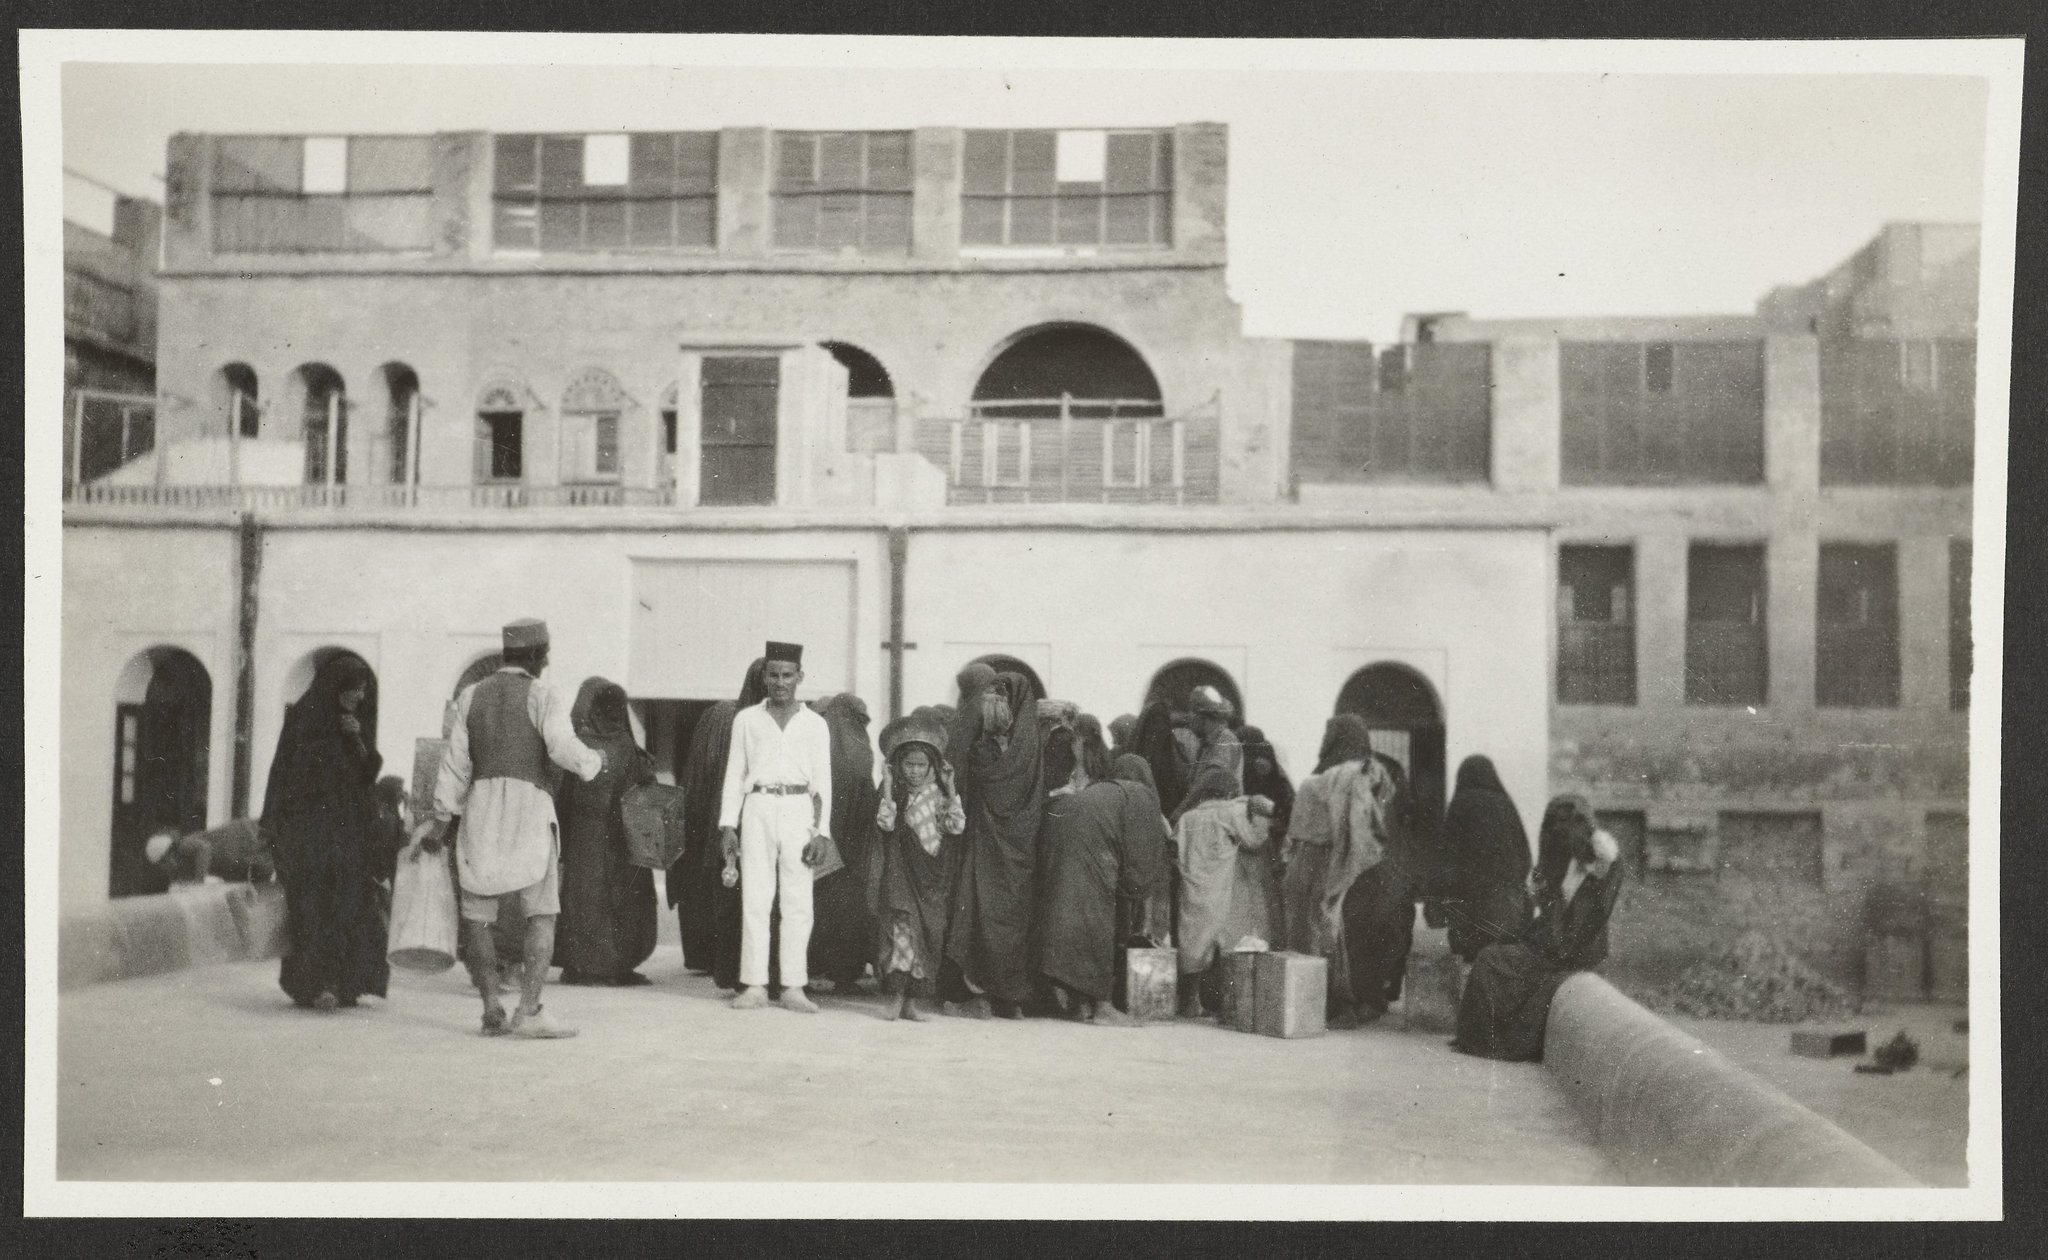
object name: photograph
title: Watertank waaruit Arabische vrouwen water halen te Bushire, Perzië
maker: a.g.a. van eelde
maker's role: engineer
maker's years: 1862-1950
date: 1925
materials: cardboard, paper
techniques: gelatin silver print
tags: iran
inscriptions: number: ‘11.’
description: Titel op object afkomstig uit inventaris (Verklaring der Photo's) behorend bij het album.